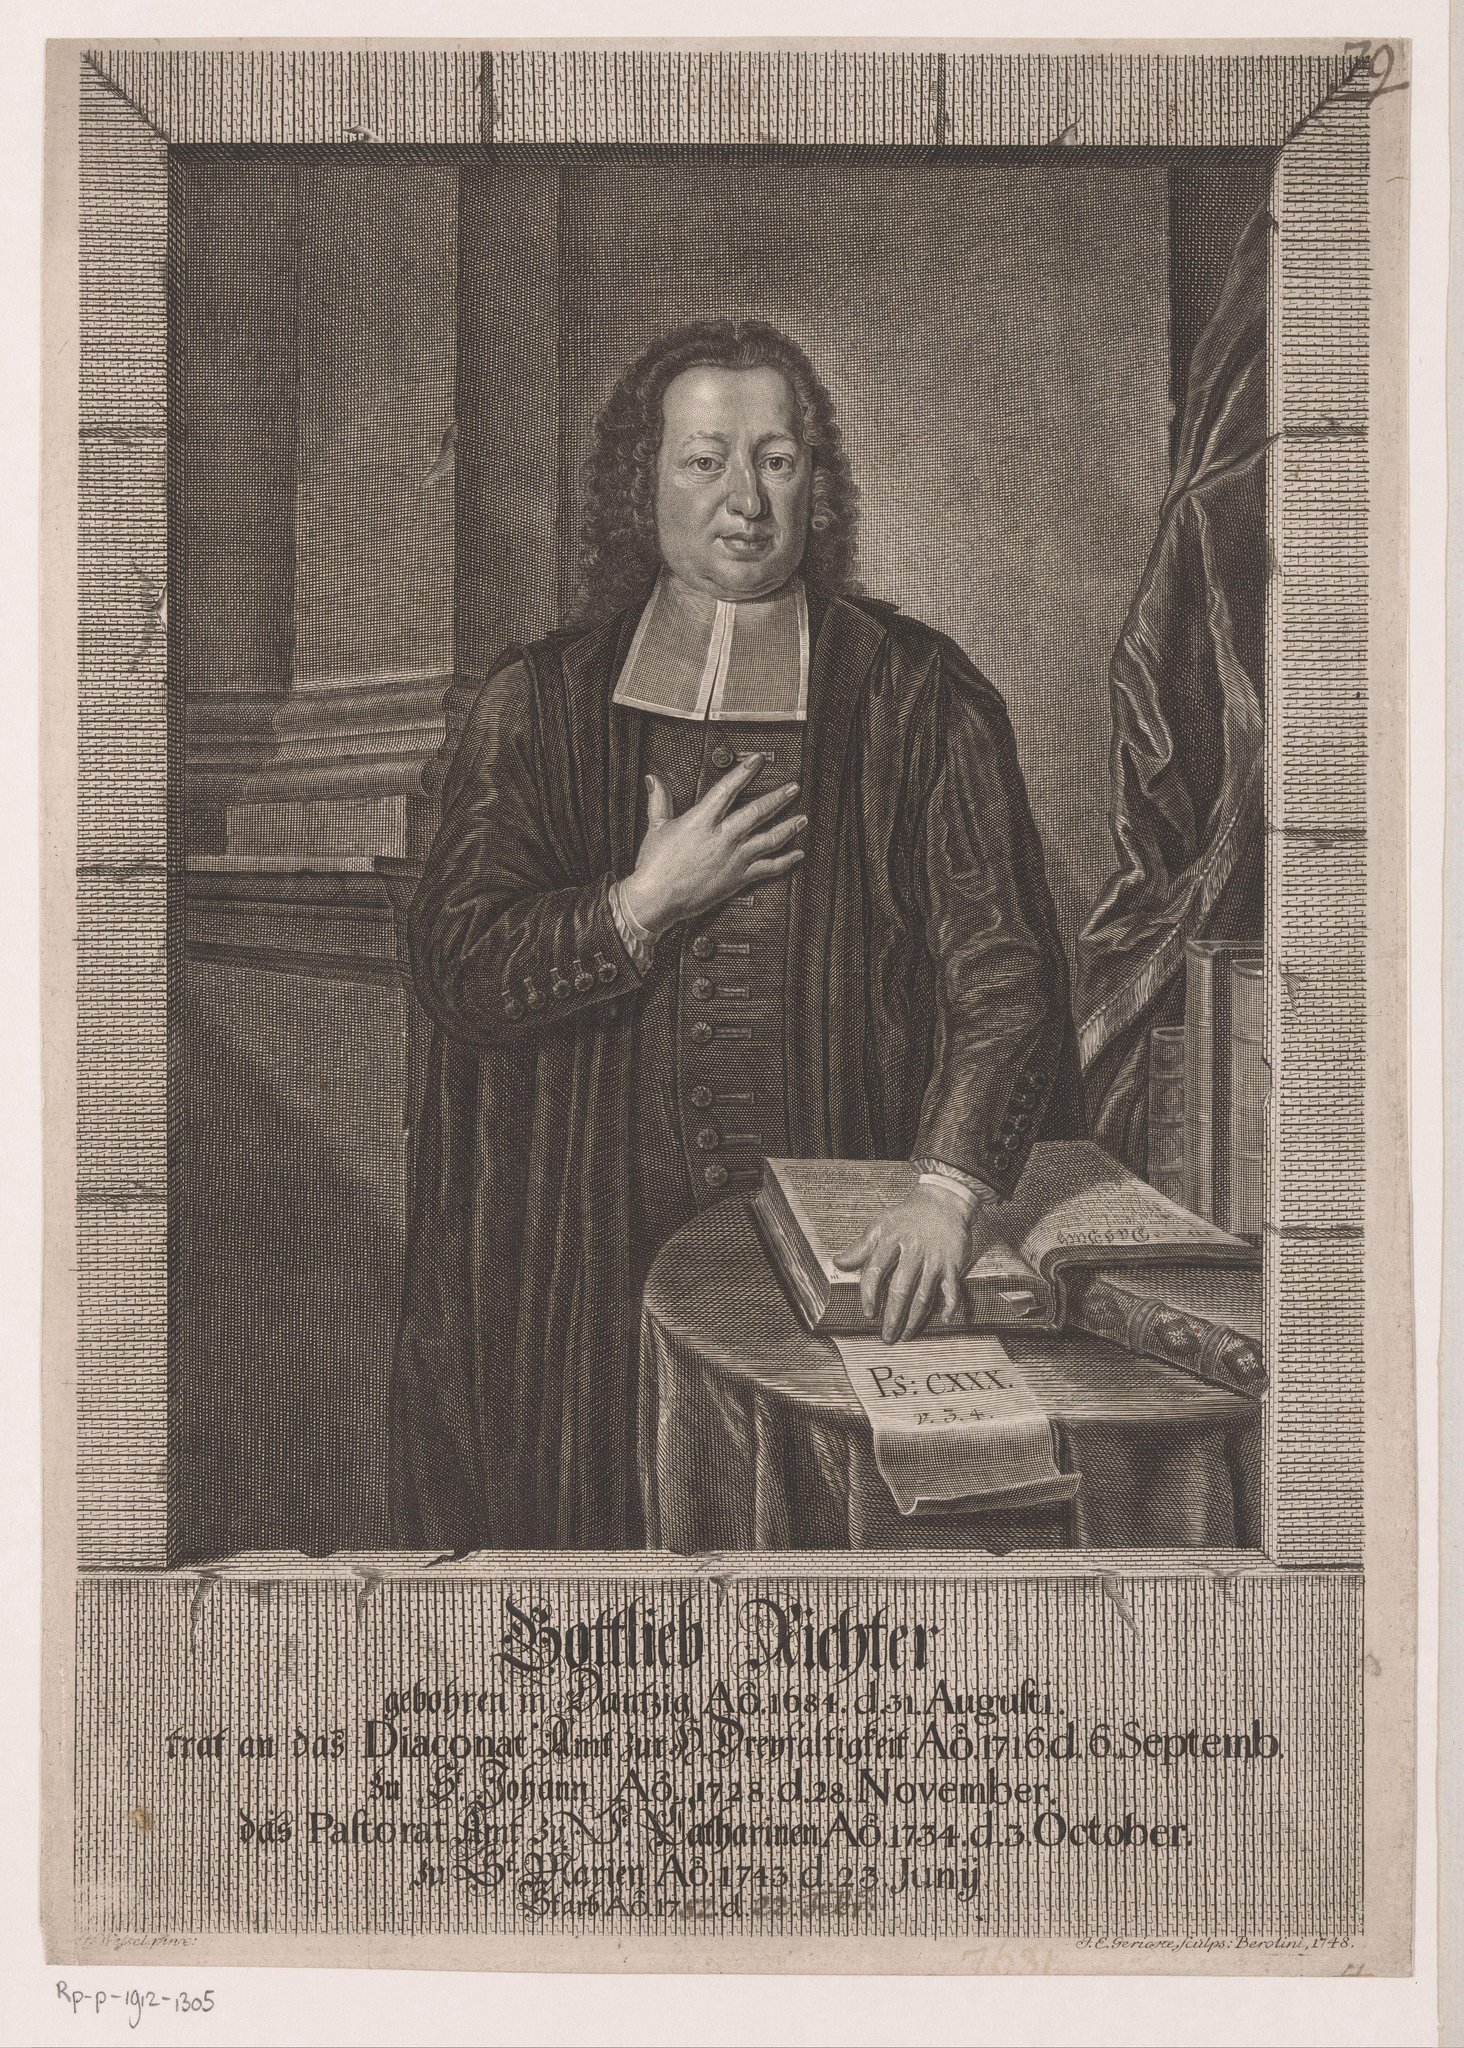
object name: print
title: Portret van Gottlieb Richter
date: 1748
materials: paper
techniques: engraving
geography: berlin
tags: theologian, historical persons, book, the book of psalms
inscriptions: inscription: ‘52 22 Febr.’, collector's mark: Lugt 2228